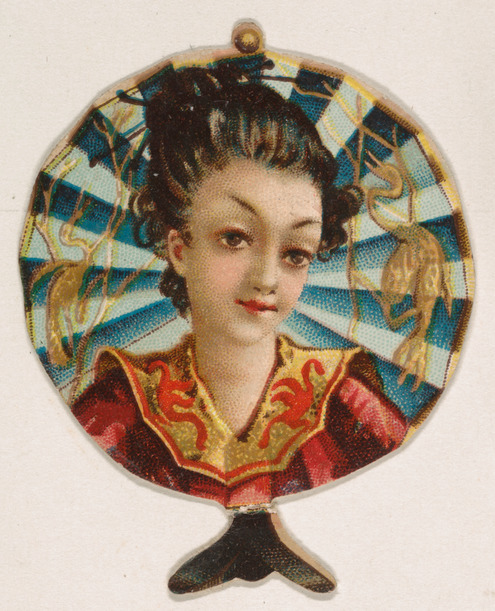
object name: print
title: Firescreen with Japanese design, from the Novelties series (N228, Type 3) issued by Kinney Bros.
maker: kinney brothers tobacco company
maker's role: publisher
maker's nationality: american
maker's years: 1869-2011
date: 1889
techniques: color lithograph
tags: birds,women